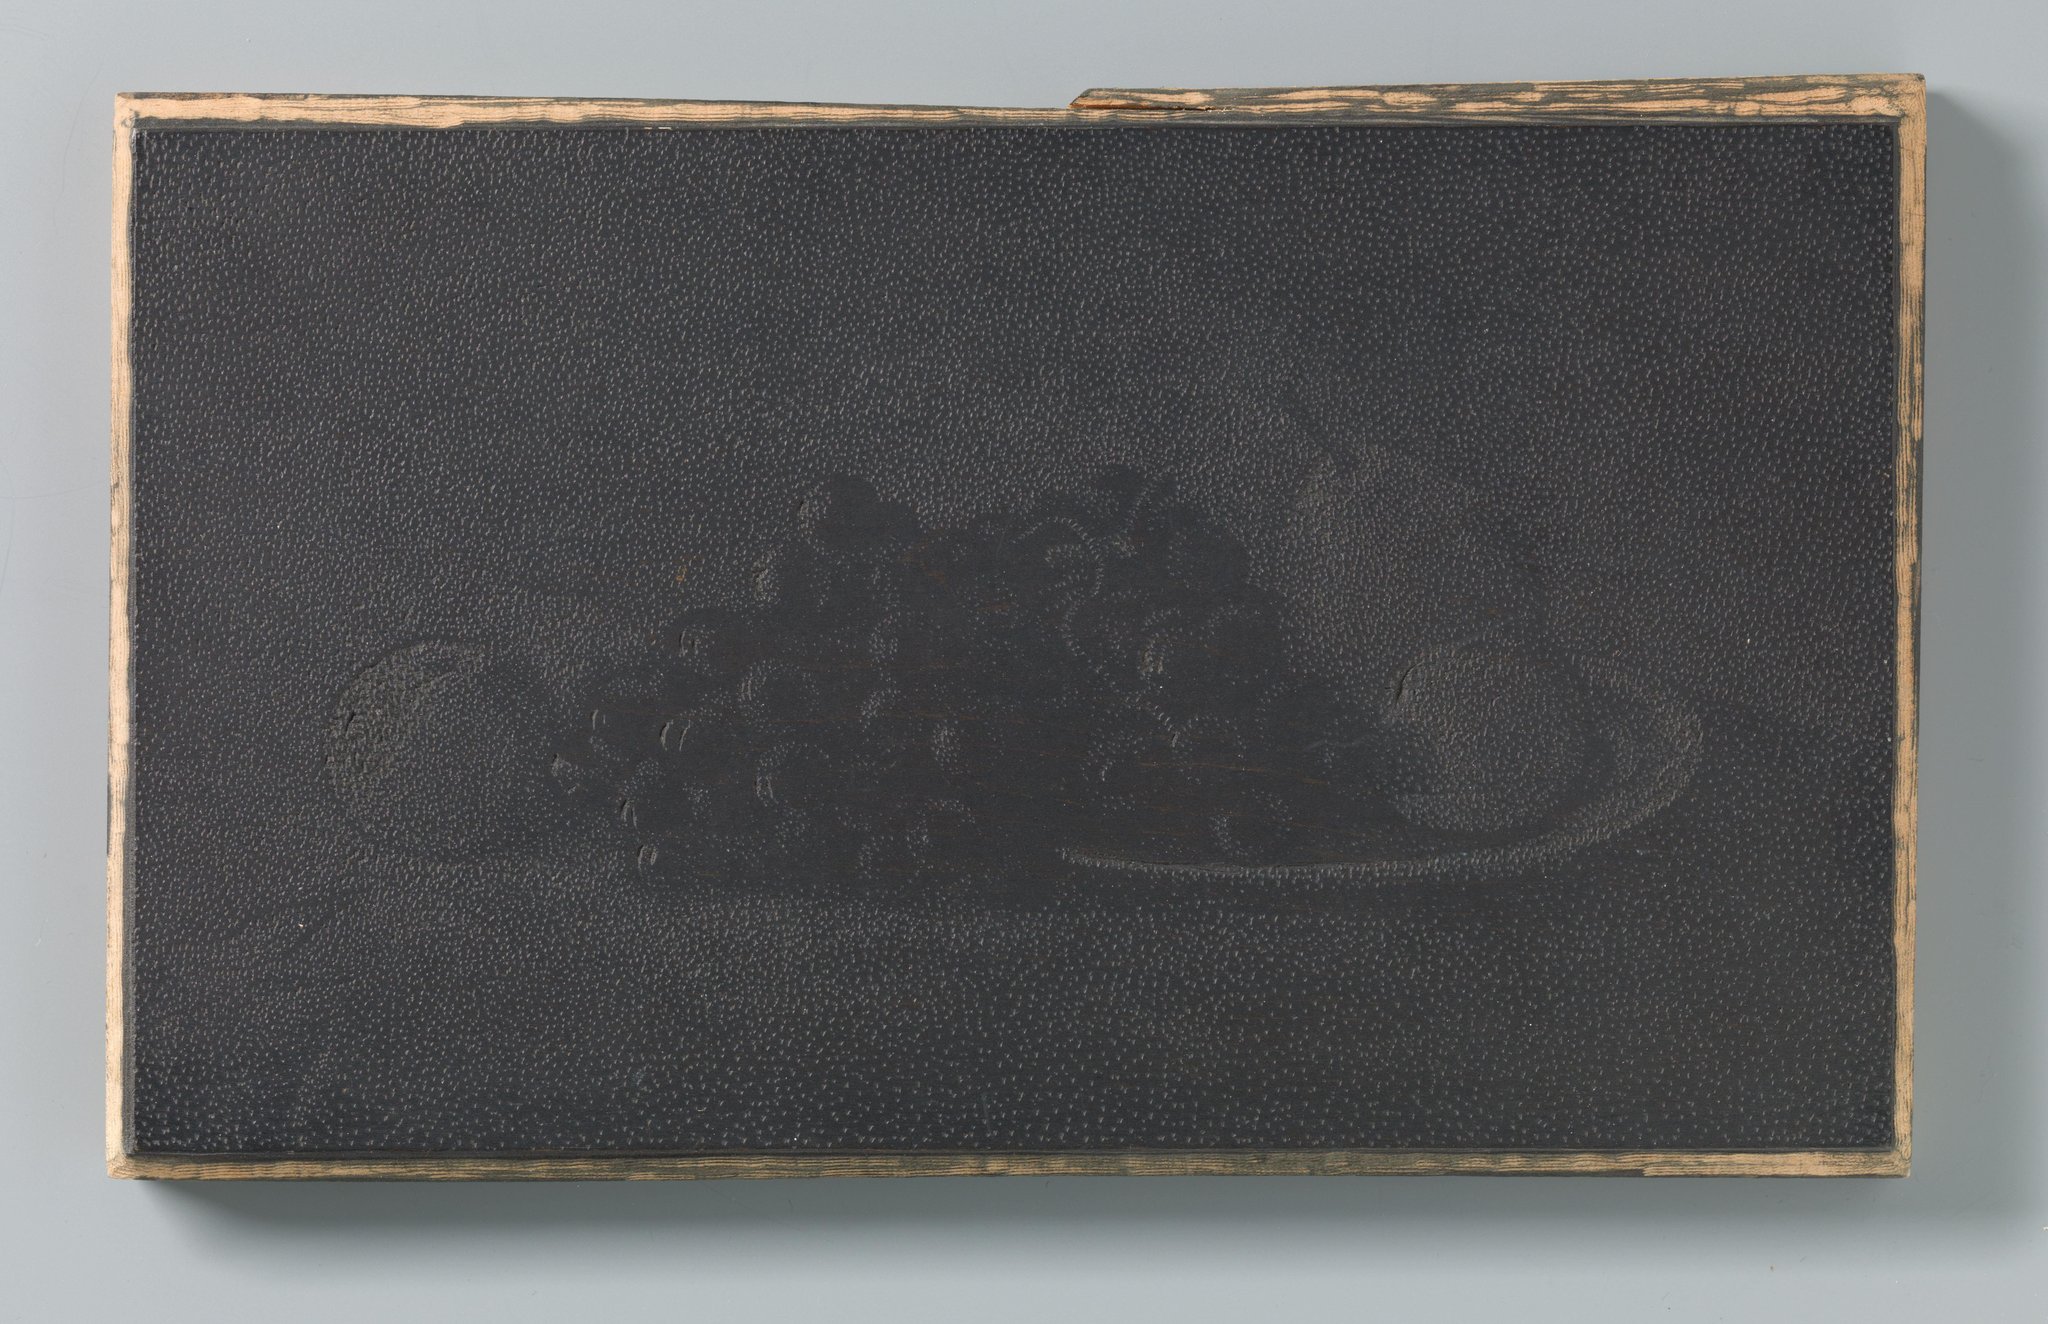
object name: wood block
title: Stilleven met druiven en peren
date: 1916-1947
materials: wood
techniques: woodcut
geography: netherlands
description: Houtblok voor de houtsnede 'Stilleven met druiven en peren'.